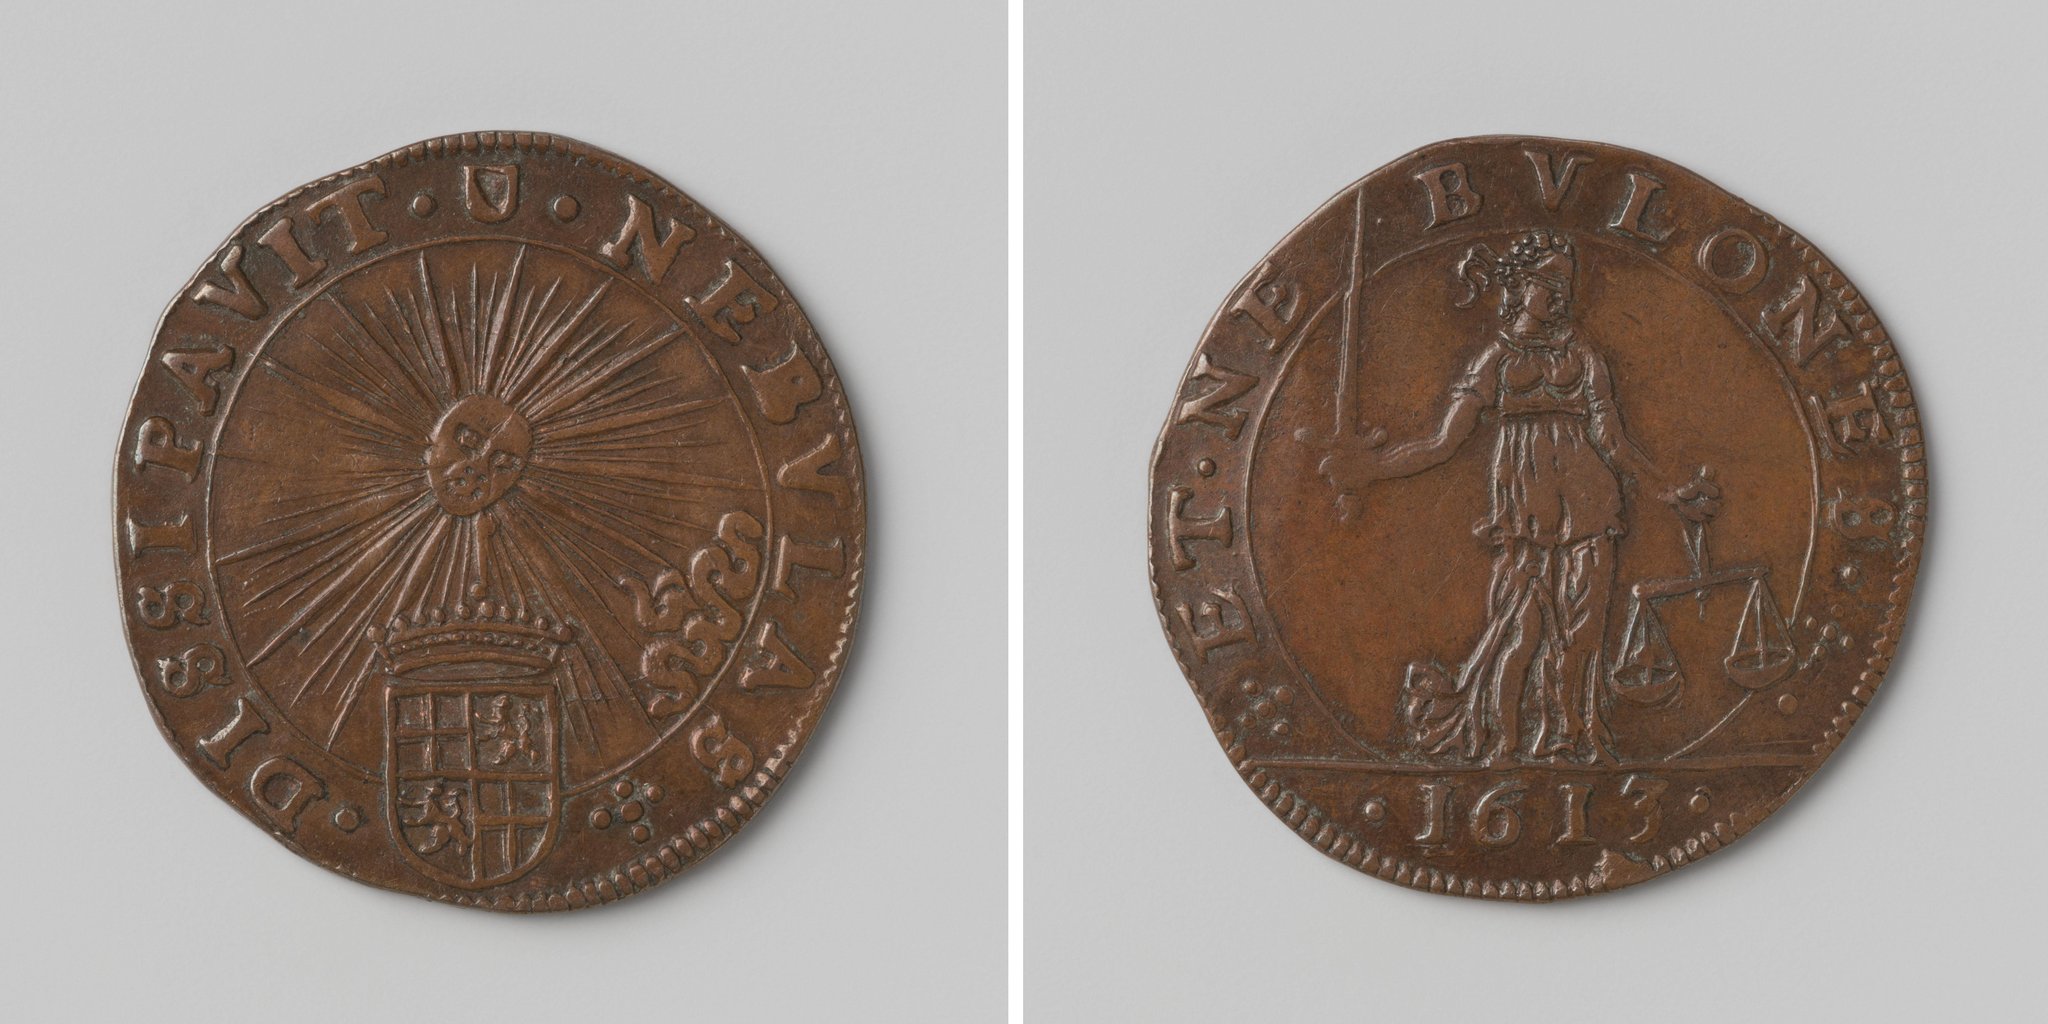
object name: jeton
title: Stillen van het oproer te Utrecht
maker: Anonymous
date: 1613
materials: copper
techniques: striking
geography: utrecht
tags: staten van zeeland, eemland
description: Koperen penning. Voorzijde: stralende zon verdrijft nevel boven gekroond wapenschild binnen omschrift. Keerzijde: Gerechtigheid met zwaard en weegschaal in handen binnen omschrift; afsnede: jaartal.